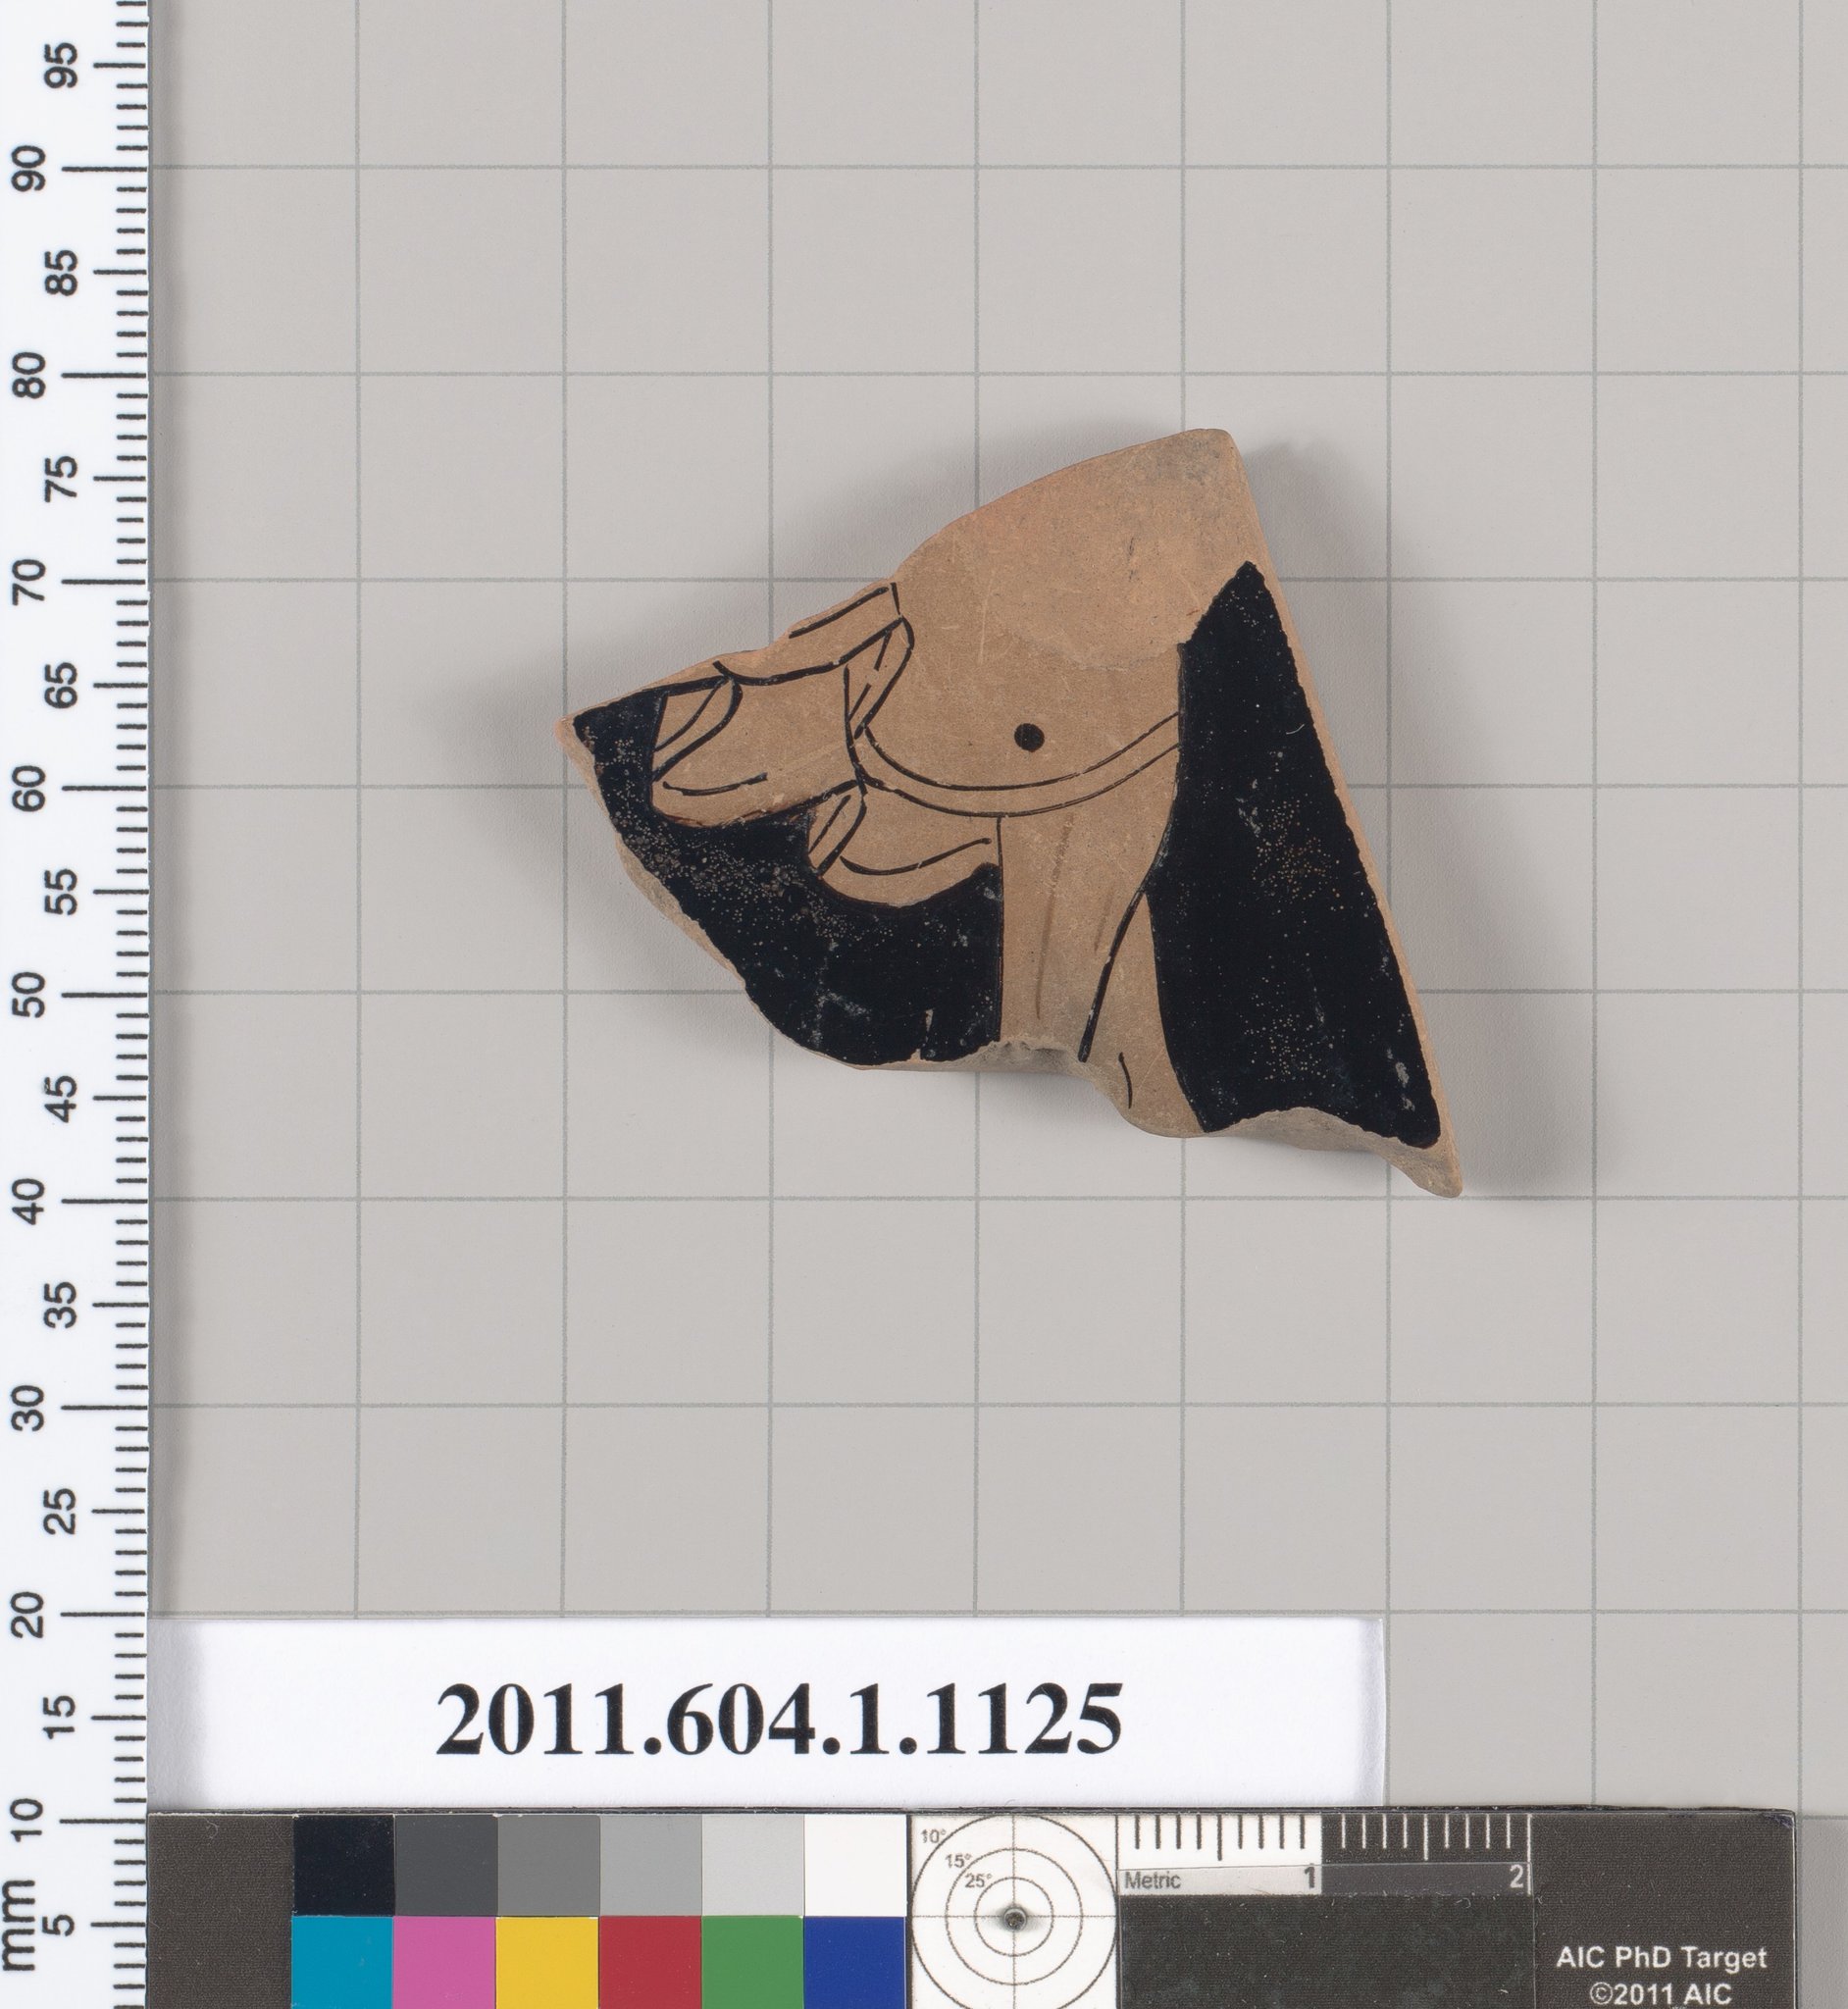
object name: kylix fragment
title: Terracotta fragment of a kylix (drinking cup)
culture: greek, attic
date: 490-480 BCE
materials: terracotta